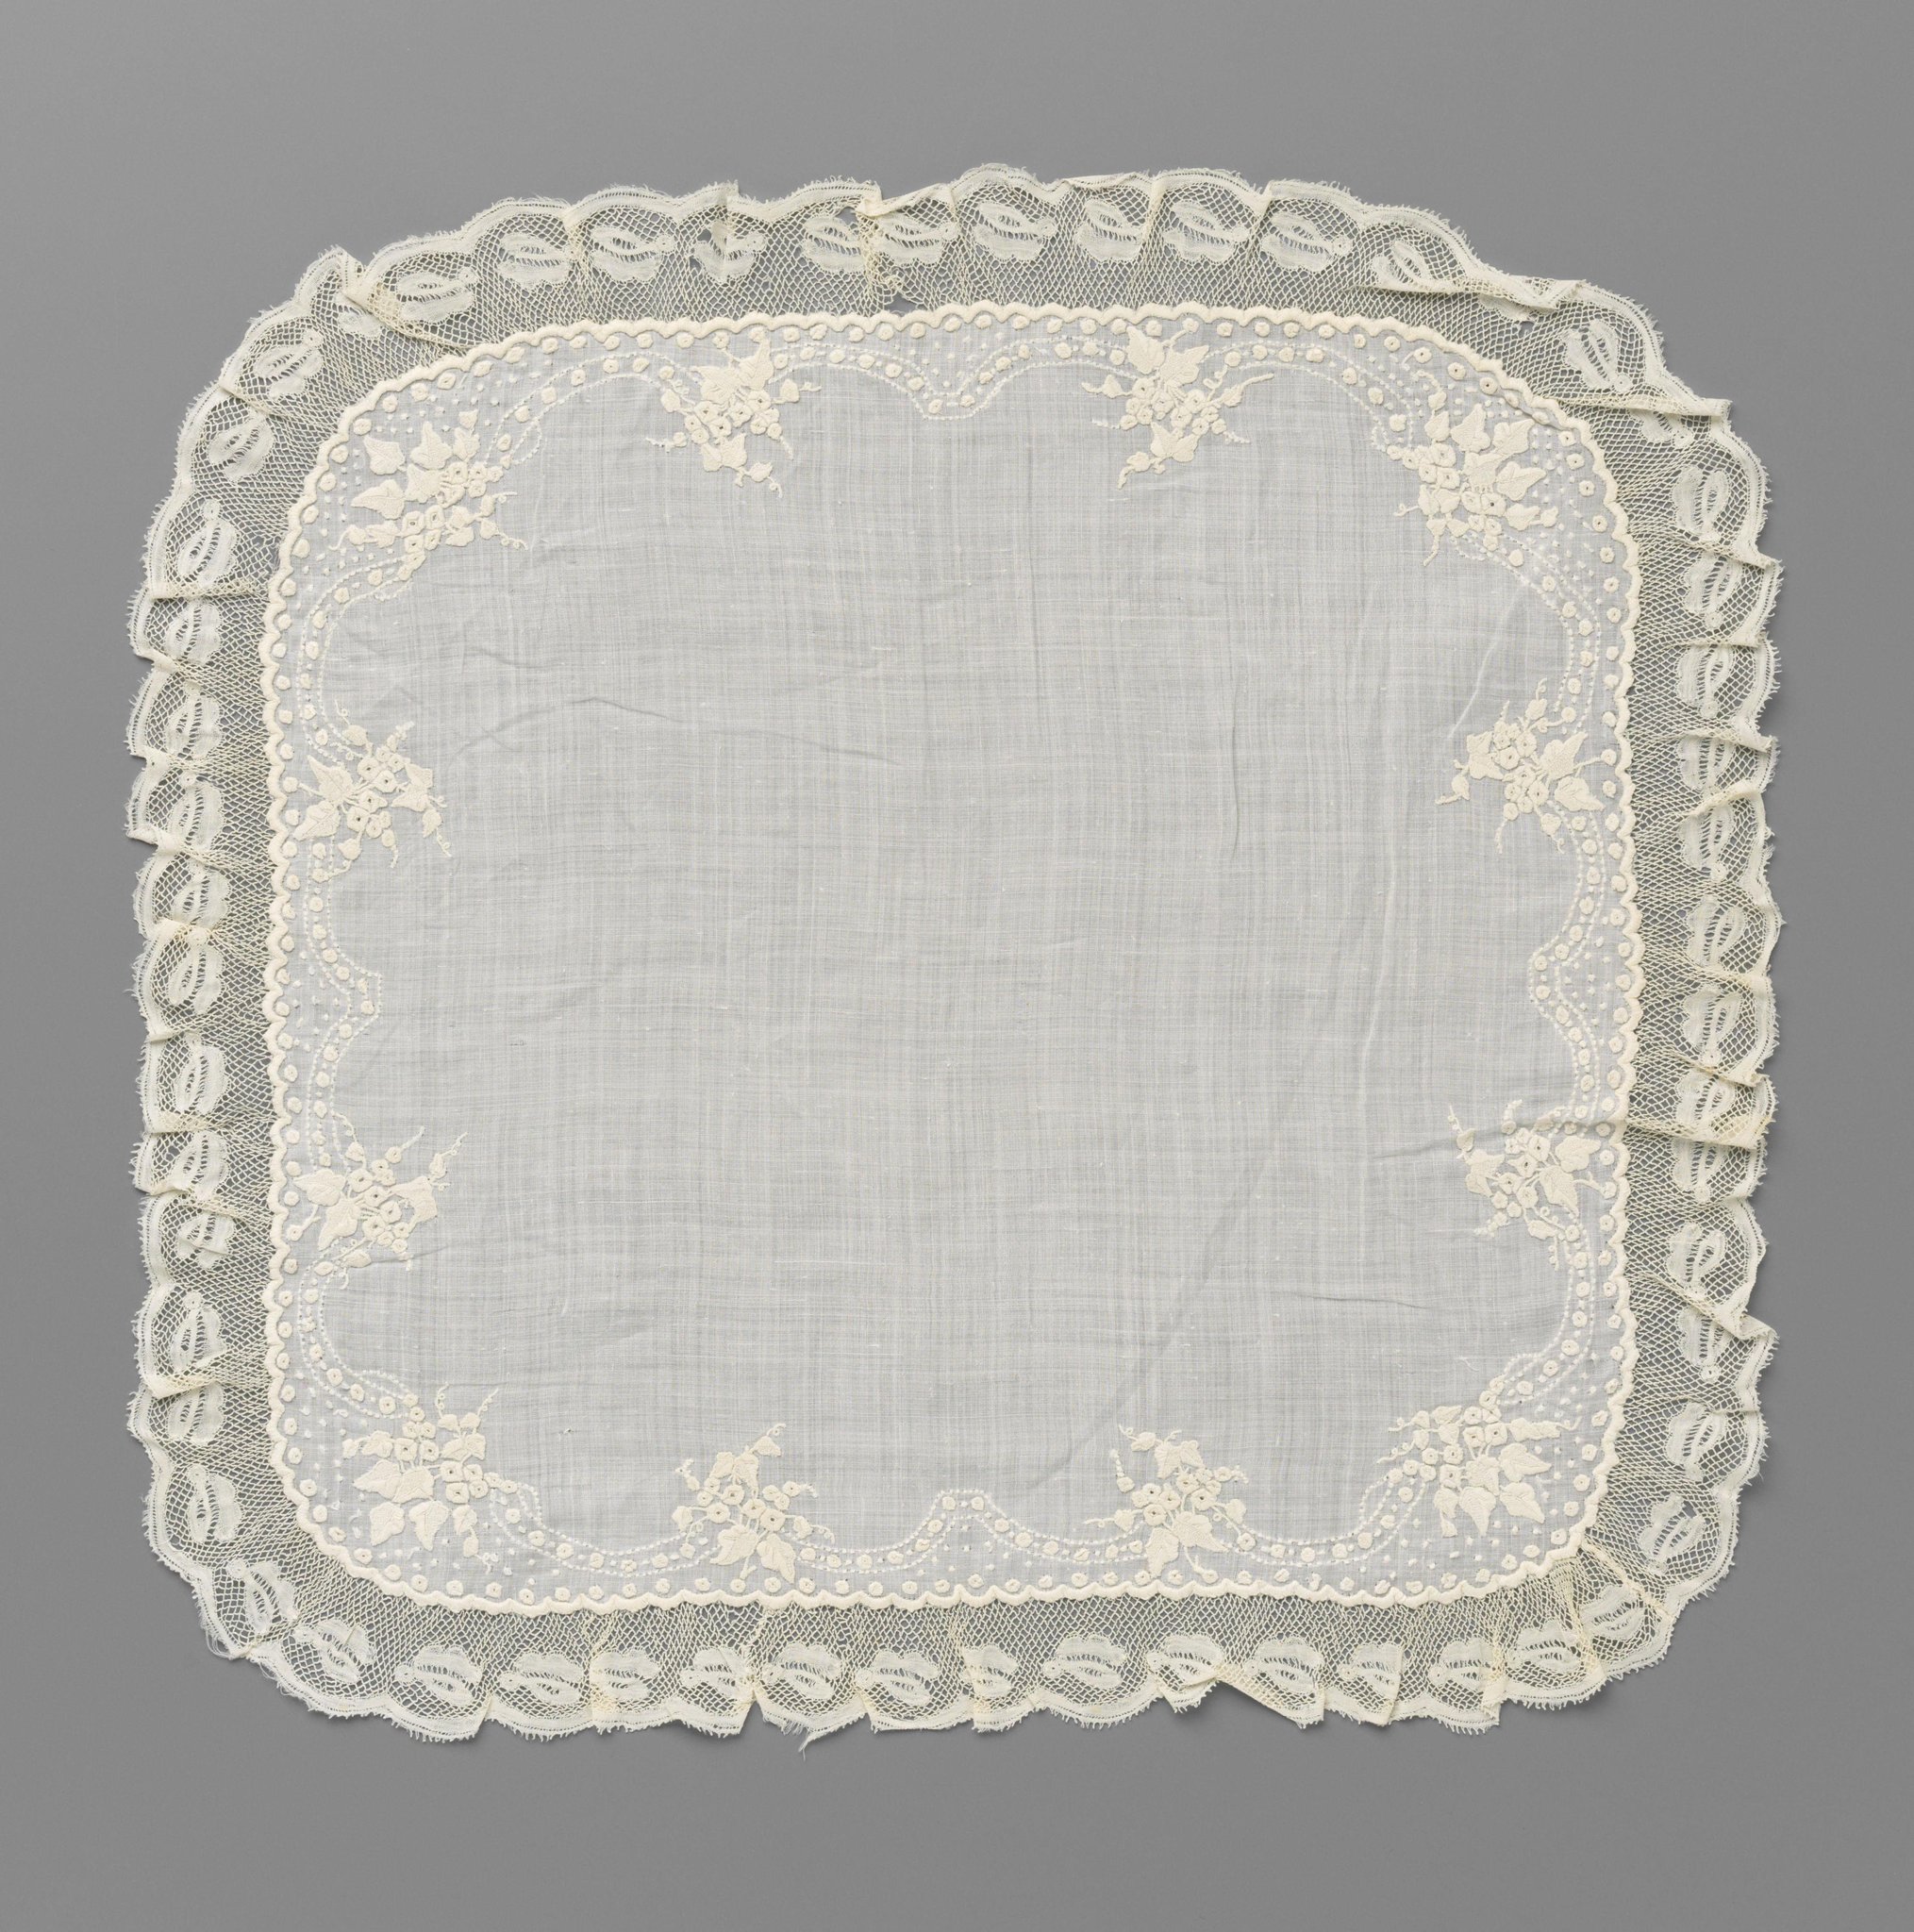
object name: womenswear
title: Batisten zakdoek met plumetis borduurwerk en een rand Valenciennes-kant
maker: Anonymous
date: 1850-1860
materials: cotton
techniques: lace, embroidered, weave, embroidery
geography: europe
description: Zakdoek van naturelkleurige batist met borduurwerk - witwerk- met rondom een rand kloskant: Valenciennes-kant. Vierkant model met afgeronde hoeken. Het borduurwerk bevindt zich langs de randen en bestaat uit boeketjes met klimopbladeren en vergeet-mij-nietjes. De twaalf boeketjes zijn op gelijke afstand van elkaar geplaatst en met elkaar verbonden door een sierband van rozetbloempjes en stipjes tussen twee stippellijnen. De rand van het batist is met kleine regelmatige schulpjes afgewerkt, met in elk schulpje een rozetbloempje. De strook kant is gerimpeld aan het batist gezet. Het heeft een schulpenrand met aaneengesloten gefestonneerde boogjes. In elke schulp staat eenzelfde, iets schuin geplaatst blad. De motieven zijn gemaakt in linnenslag met opengewerkte randjes en uitsparingen. Ze zijn met elkaar verbonden door een vierkante Valenciennes-grond. De schulpenrand is afgewerkt met picots.